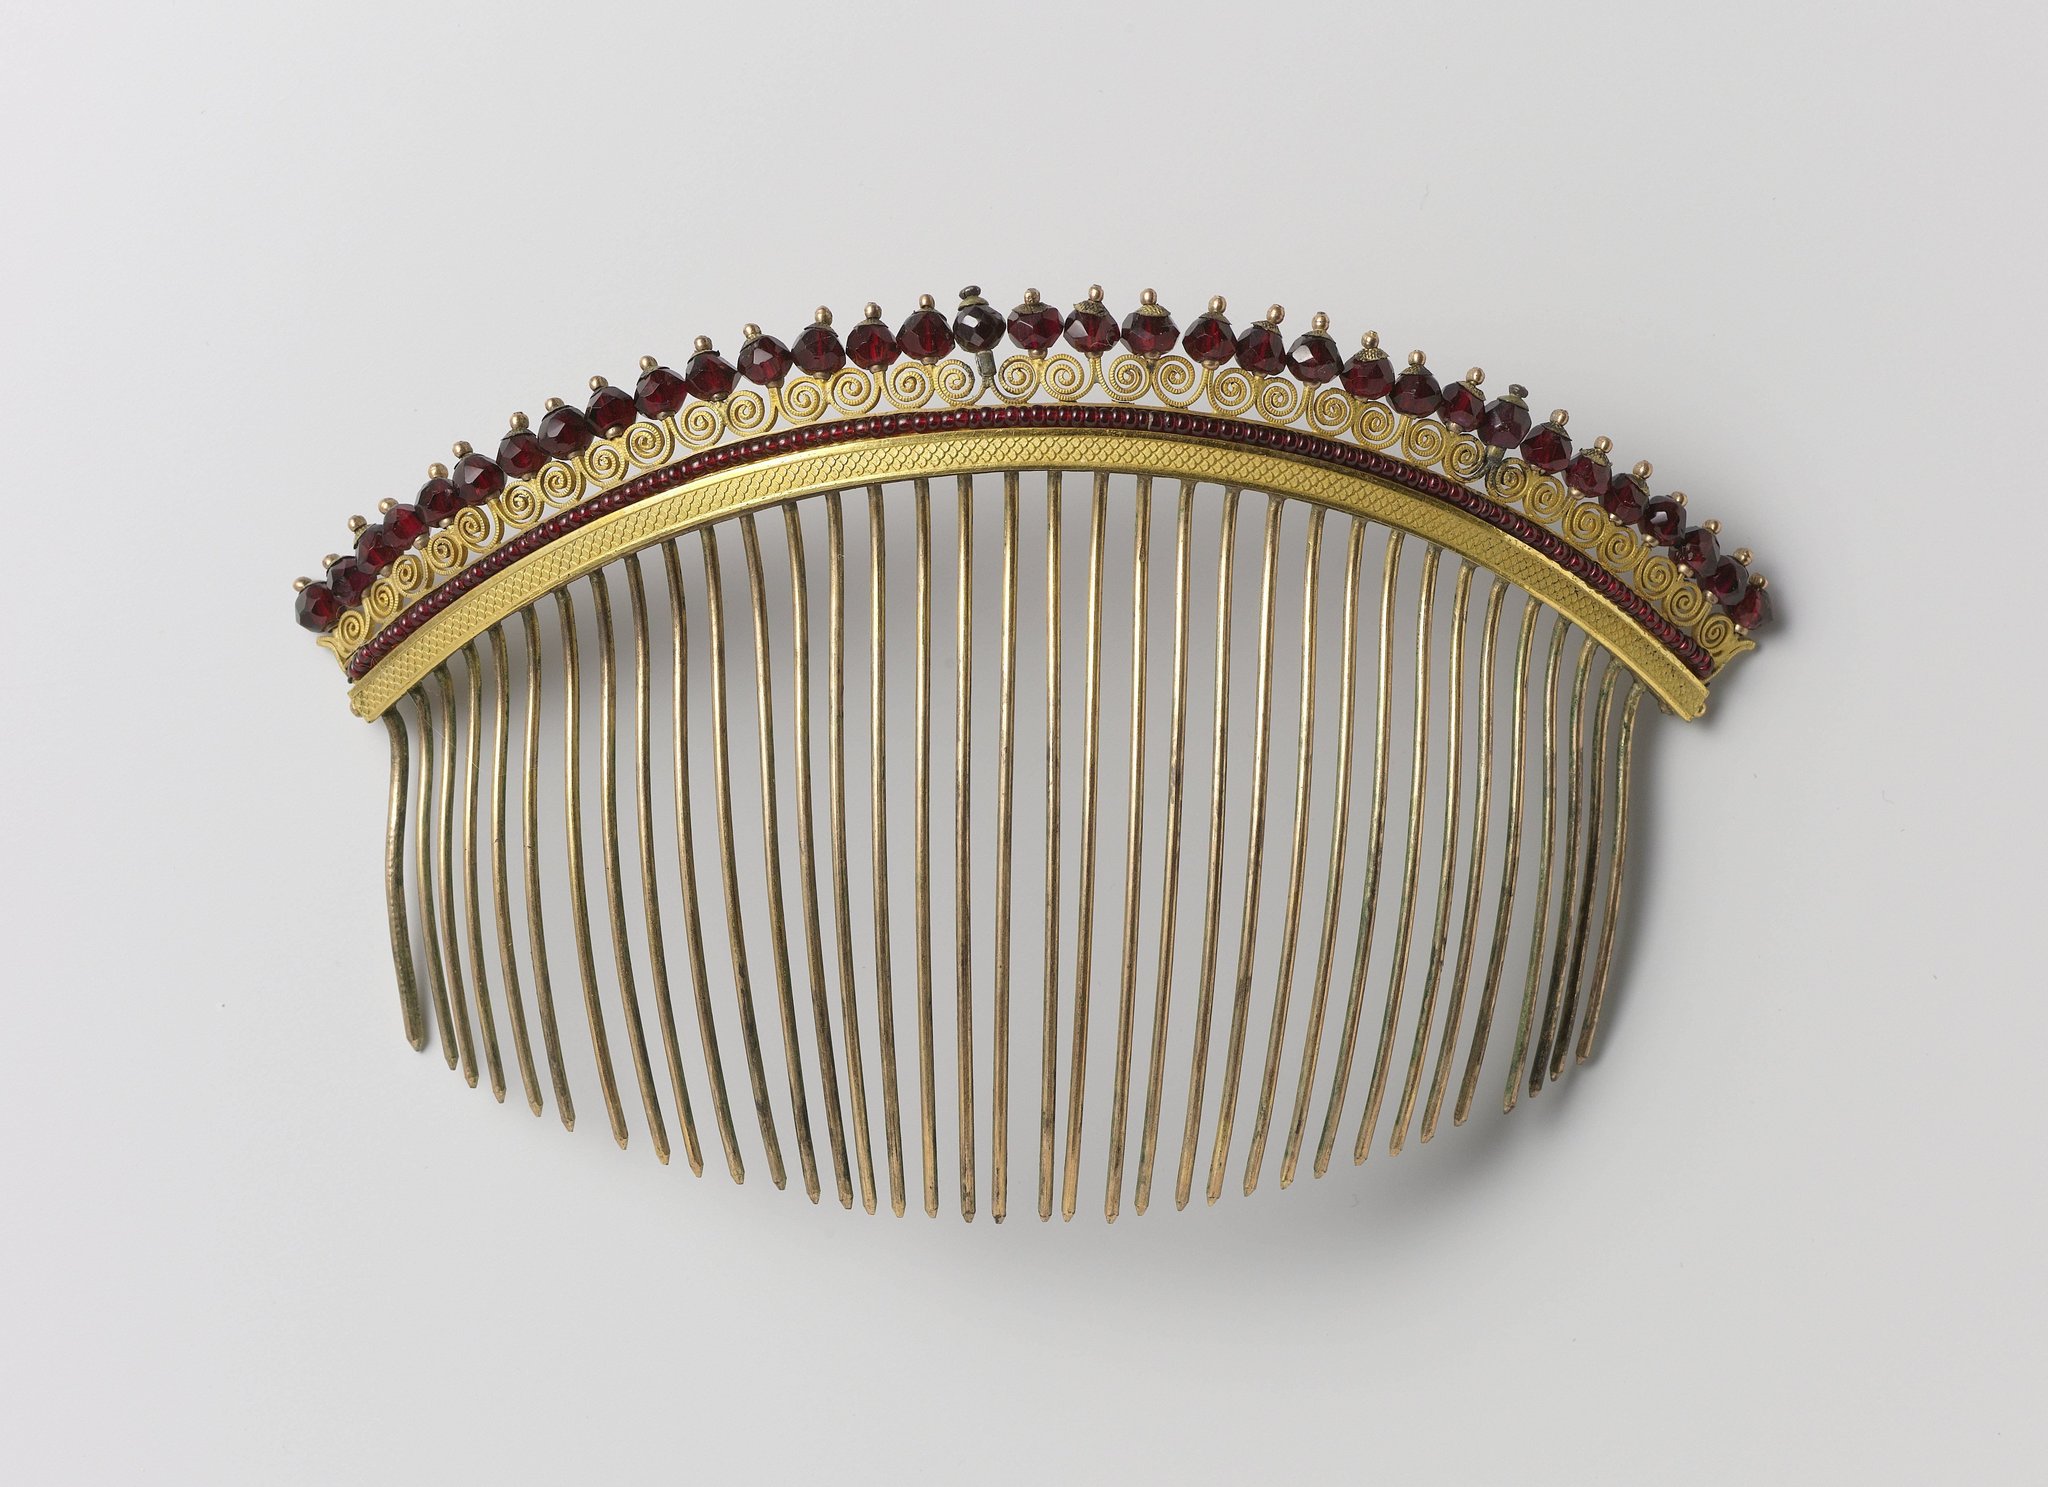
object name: diadem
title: Comb or diadem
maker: Anonymous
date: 1820-1830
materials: copper, gemstone, glass, gold leaf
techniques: forging, grinding, polish, sawing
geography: netherlands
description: The mount of this comb harks back to examples from Classical antiquity. Characteristic features are the layered construction and especially the ornamental volutes, or spiral scrolls. This comb was worn in the hair like a diadem.